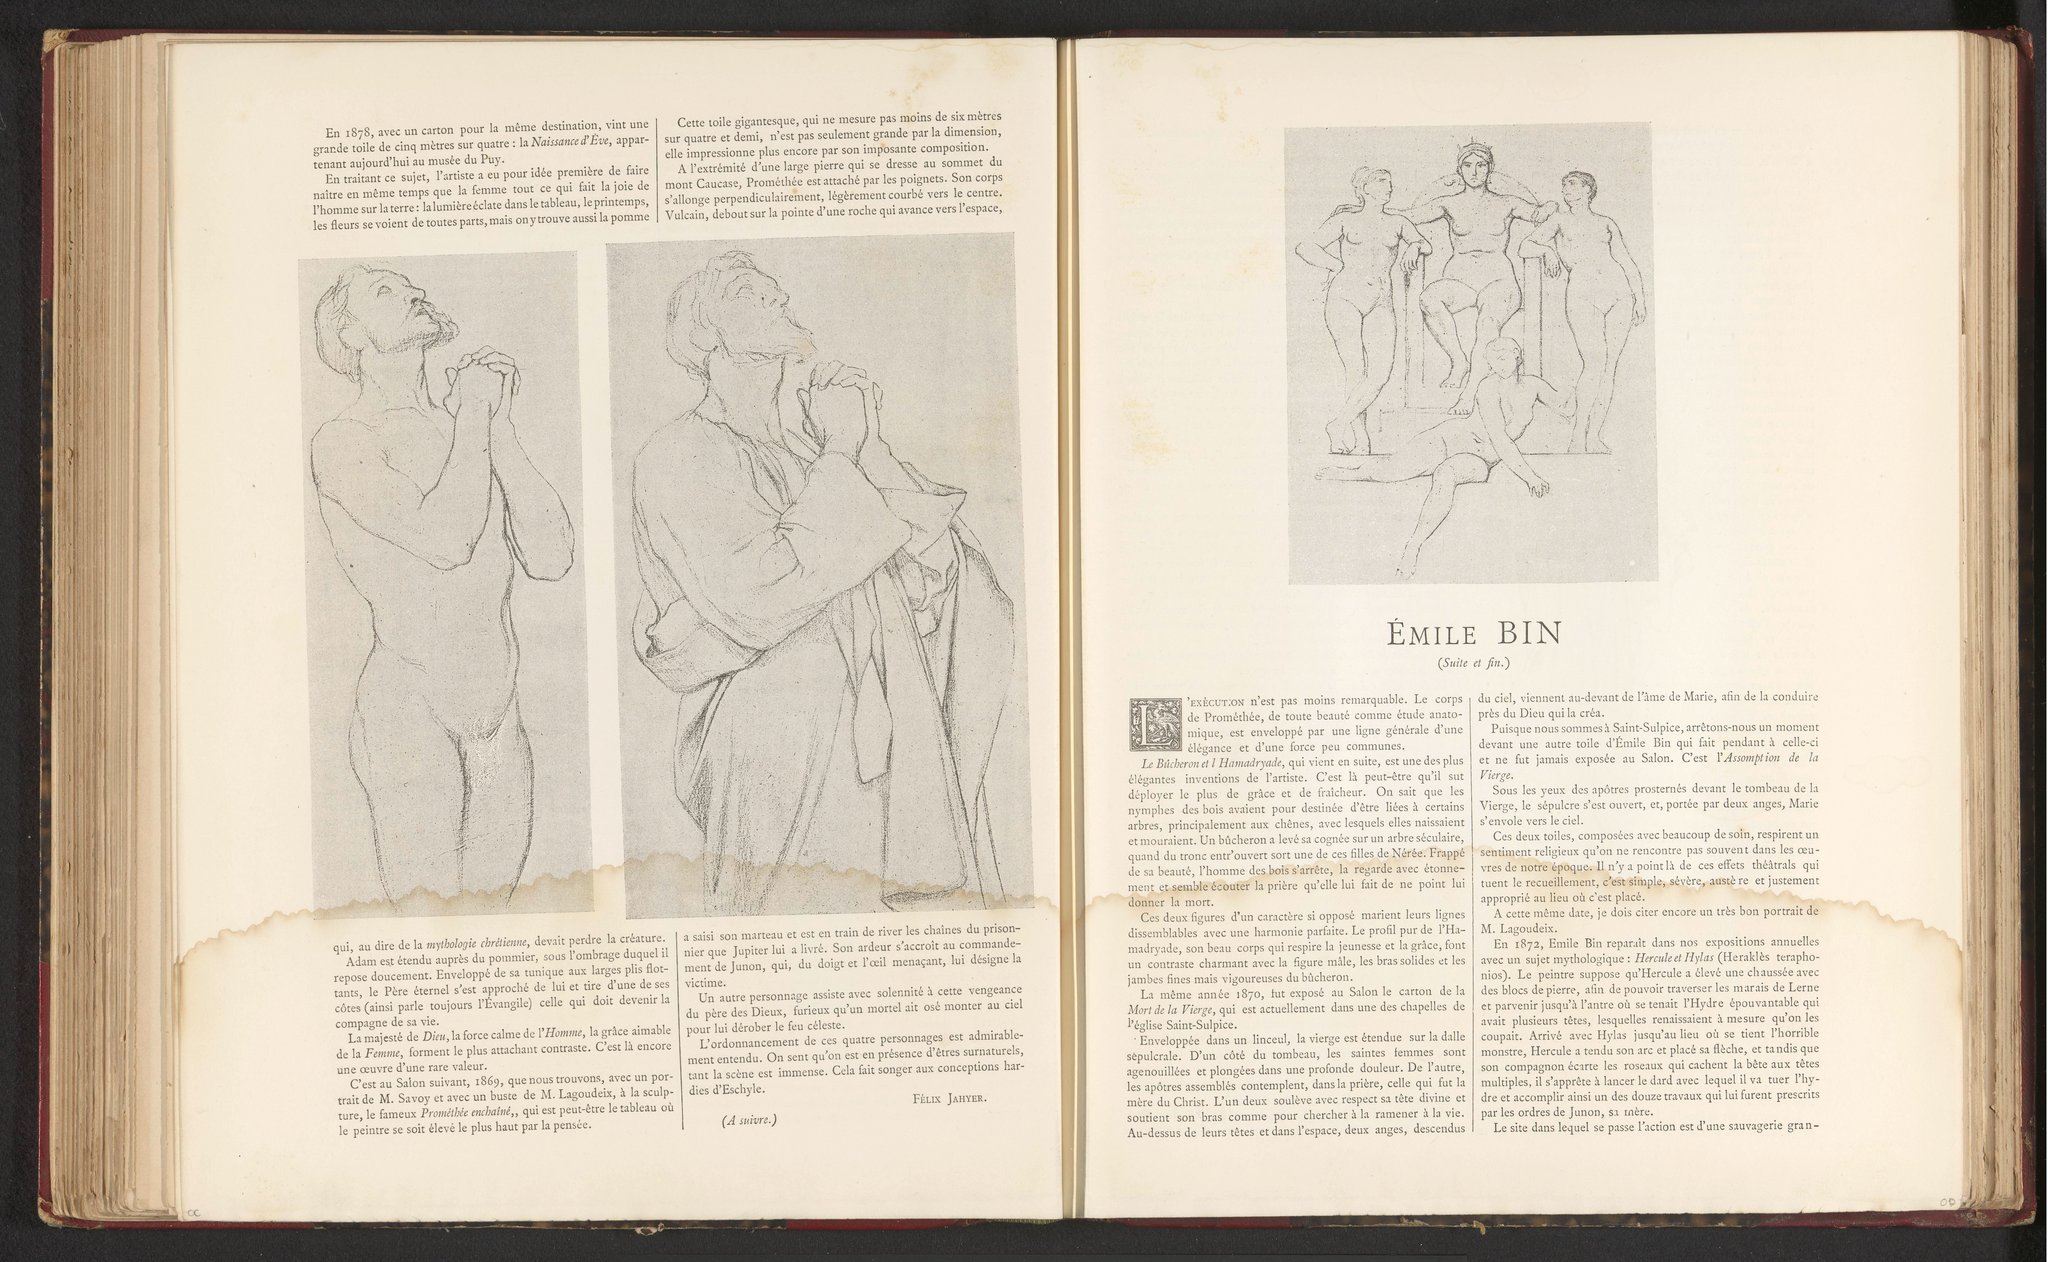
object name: photomechanical print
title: Fotoreproductie van een tekening door vermoedelijk Émile Bin, voorstellend een gekroonde vrouw op een troon met drie vrouwen ernaast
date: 1876-1879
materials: paper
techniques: autotype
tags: drawing, sketch, throne